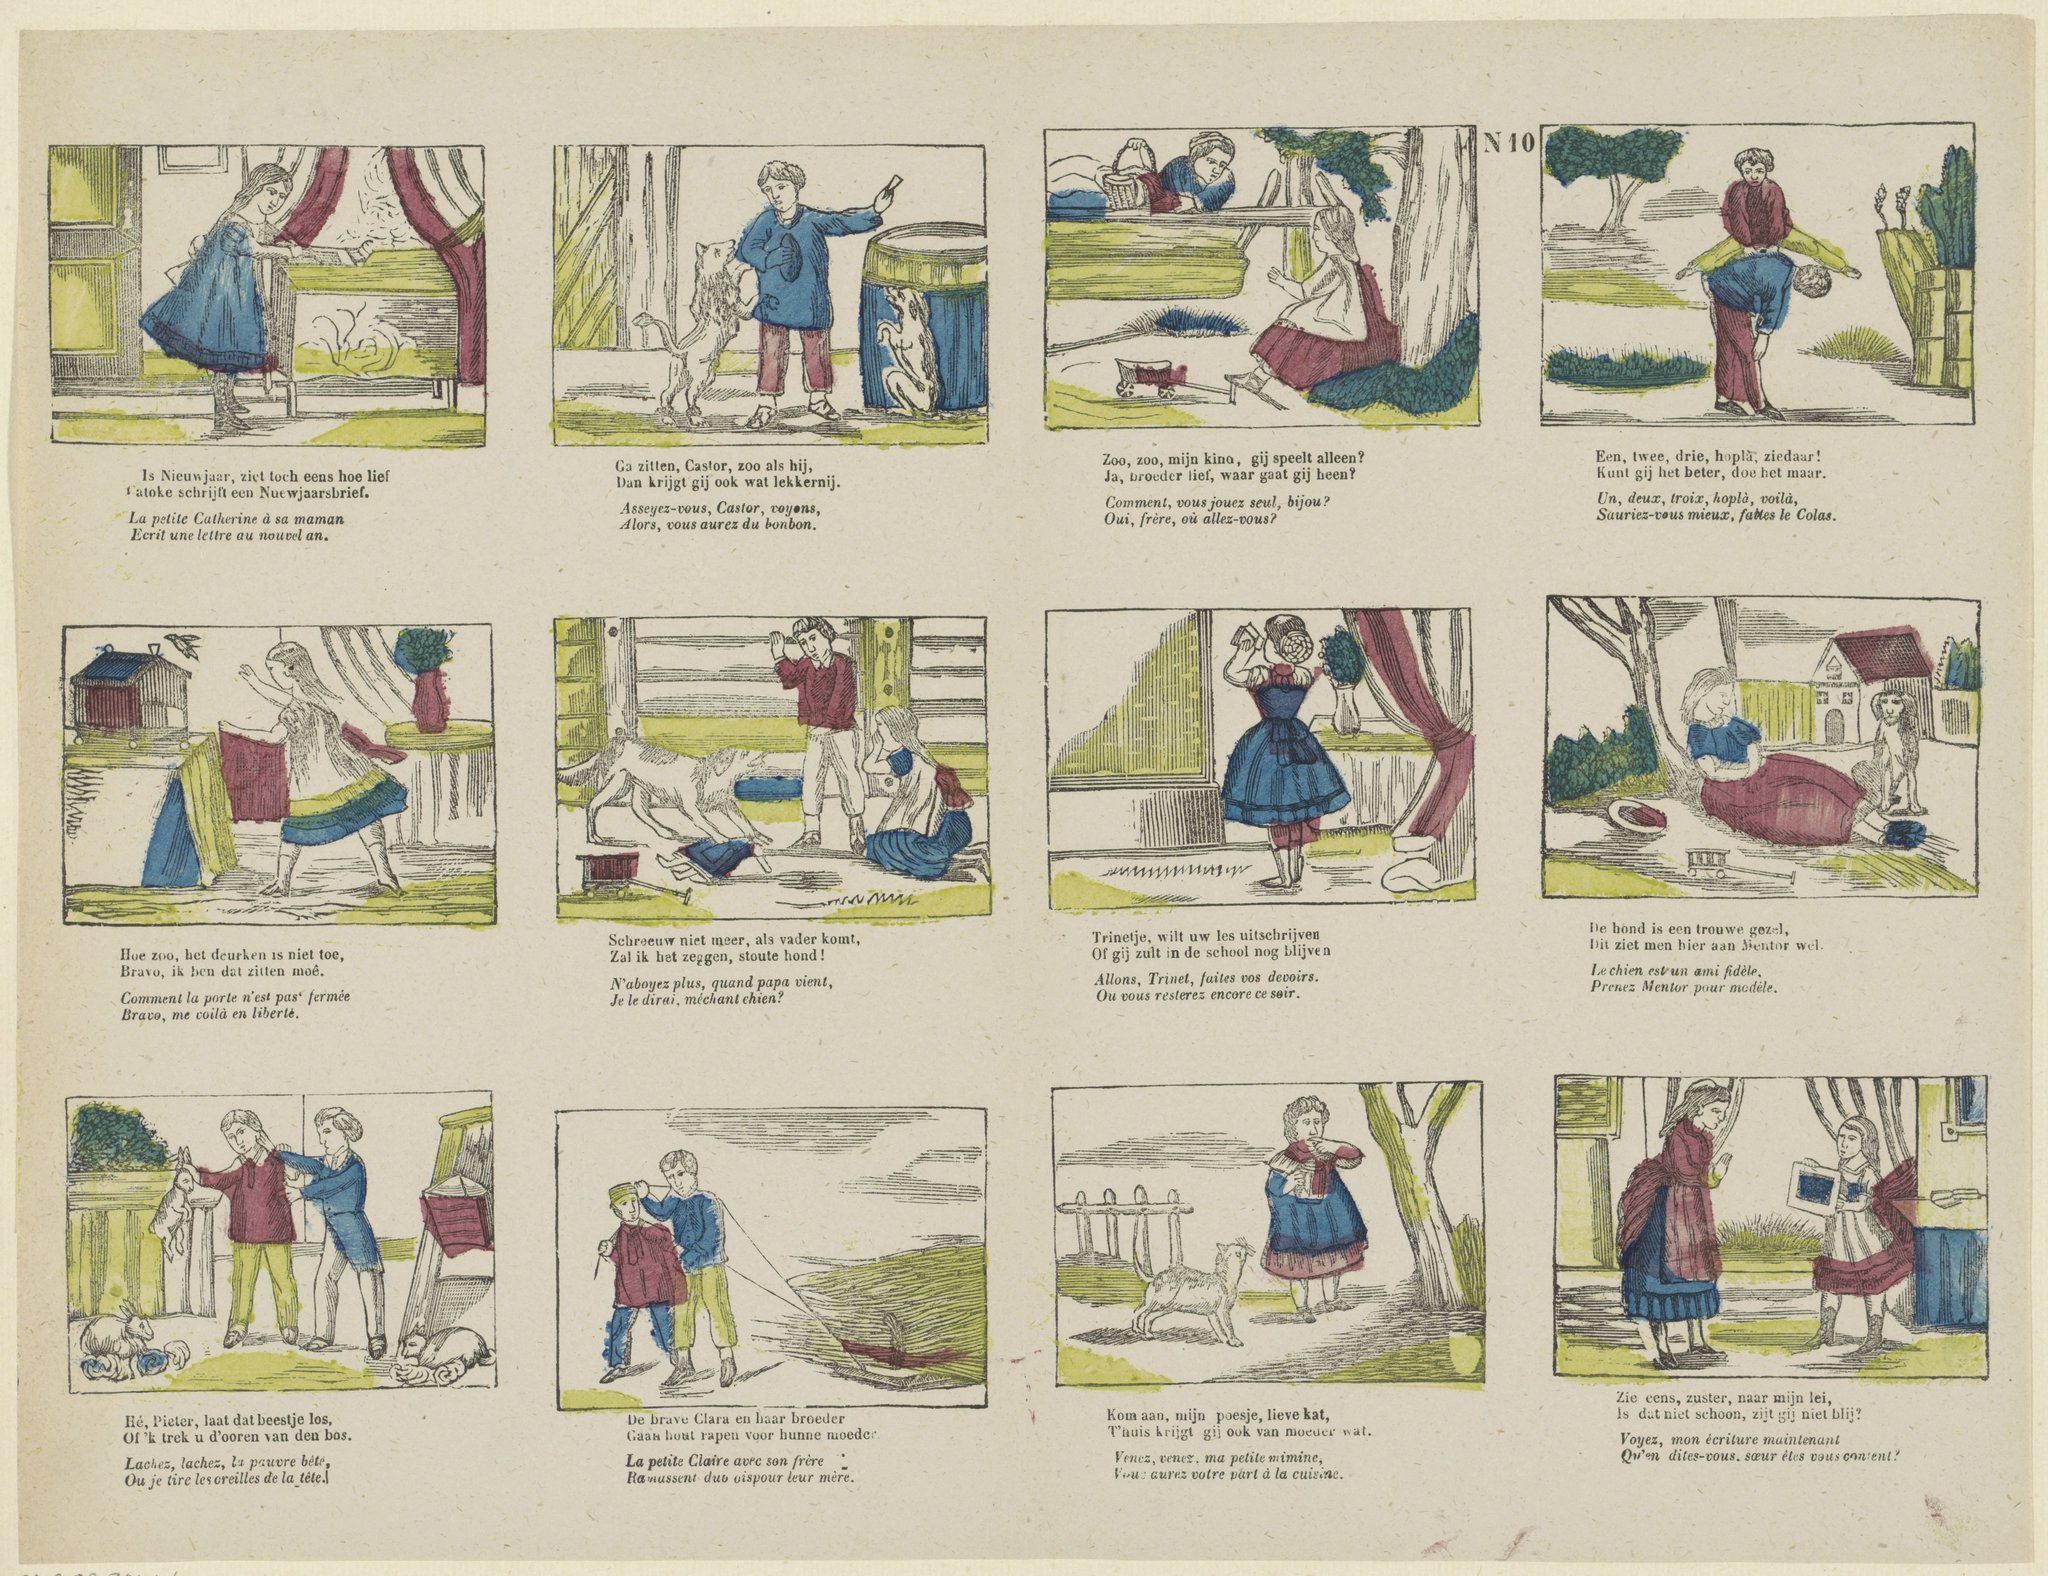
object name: popular print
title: Kinderbezigheden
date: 1866-1902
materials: paper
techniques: colour, letterpress printing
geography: turnhout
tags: education, science and learning, children's games and plays, child, child playing with animals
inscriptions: collector's mark: Lugt 2760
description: Blad met 12 voorstellingen van kinderbezigheden, waaronder spelen met dieren, spelen met andere kinderen en leren. Onder elke voorstelling een tweeregelig vers in het Nederlands en in het Frans. Genummerd midden boven: N 10.